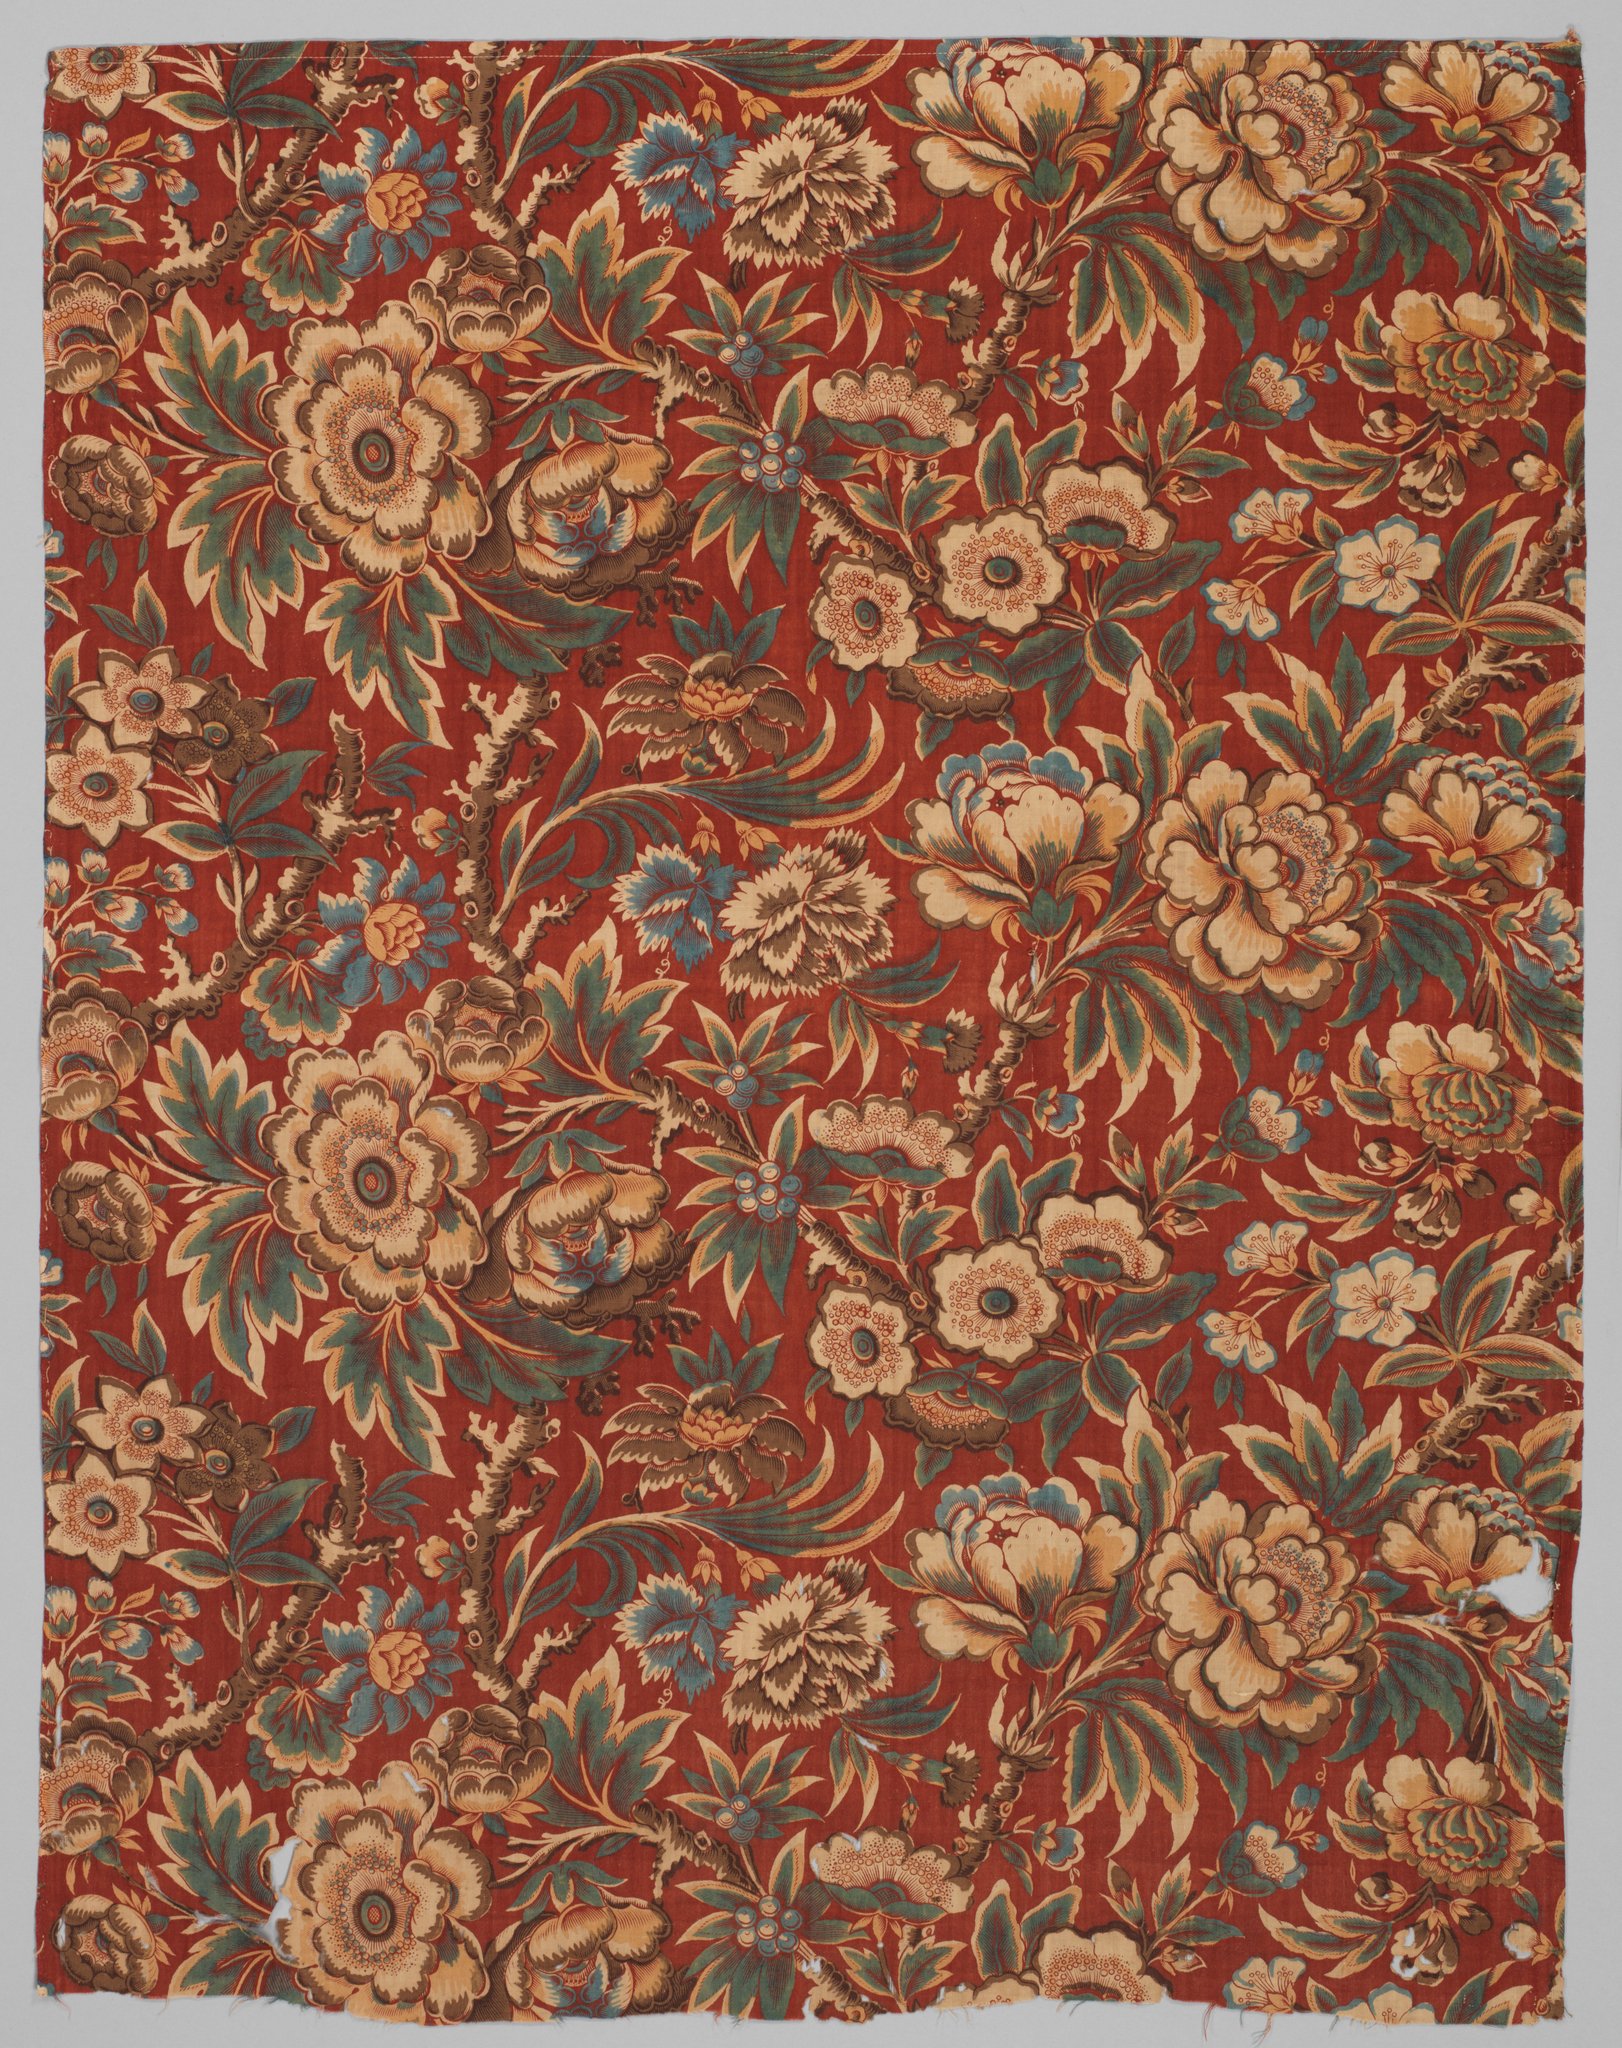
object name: piece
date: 1815-1830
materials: cotton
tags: flowers